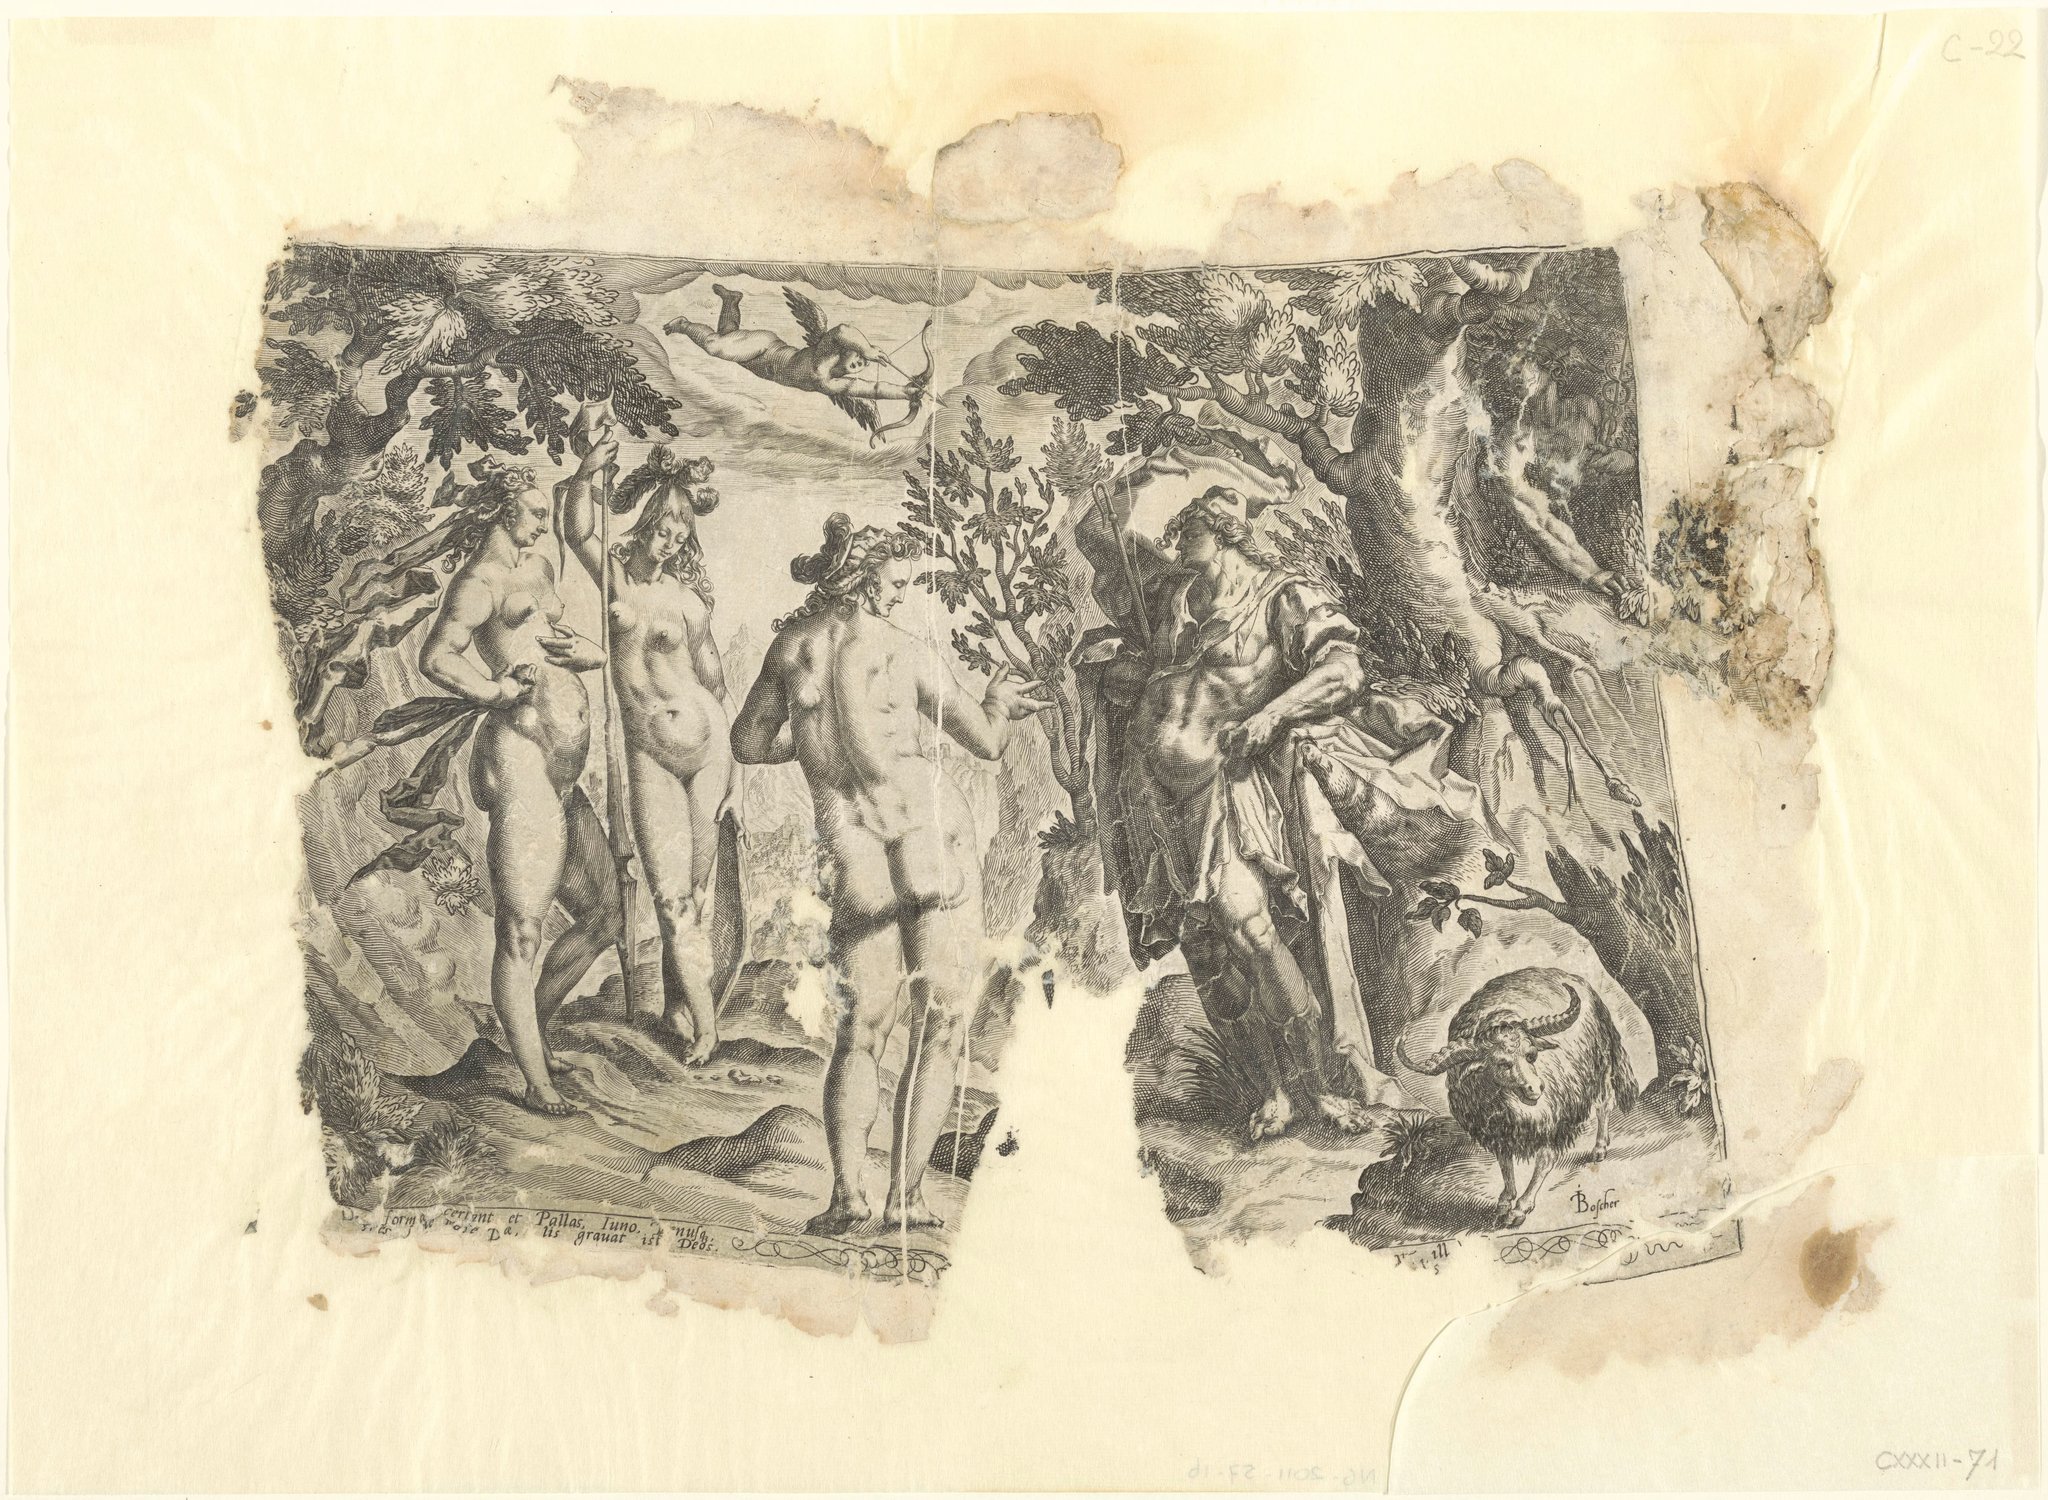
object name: print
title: Oordeel van Paris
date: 1580-1596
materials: paper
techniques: engraving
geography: amsterdam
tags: the judgement of paris (mercury present)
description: De prenten in de Nova Zembla collectie zijn tijdens een expeditie van Willem Barendsz en Jacob van Heemskerk in 1596-1597 noodgedwongen in het winterkamp, het ‘Behouden Huis’, op het eiland achtergelaten. De prenten waren in één of meerdere stapels als handelswaar meegenomen vanuit Amsterdam. Bijna drie eeuwen later, in 1871, keerde de Noor Elling Carlsen terug naar Nova Zembla en vond daar de restanten van het ‘Behouden Huis, inclusief een groot deel van de inventaris. Een deel van de prenten, in de vorm van aaneengekoekte kluiten, werd toen ook teruggevonden. De papierkluiten waren soms op meerdere plekken gebroken. Tussen 1975-1979 zijn de prenten van elkaar gescheiden. Dit leverde in totaal ca. 1000 fragmenten van ca. 400 afdrukken van ca. 150 verschillende prenten op. Voor zover mogelijk zijn de fragmenten samengevoegd en zijn de prenten gereconstrueerd.